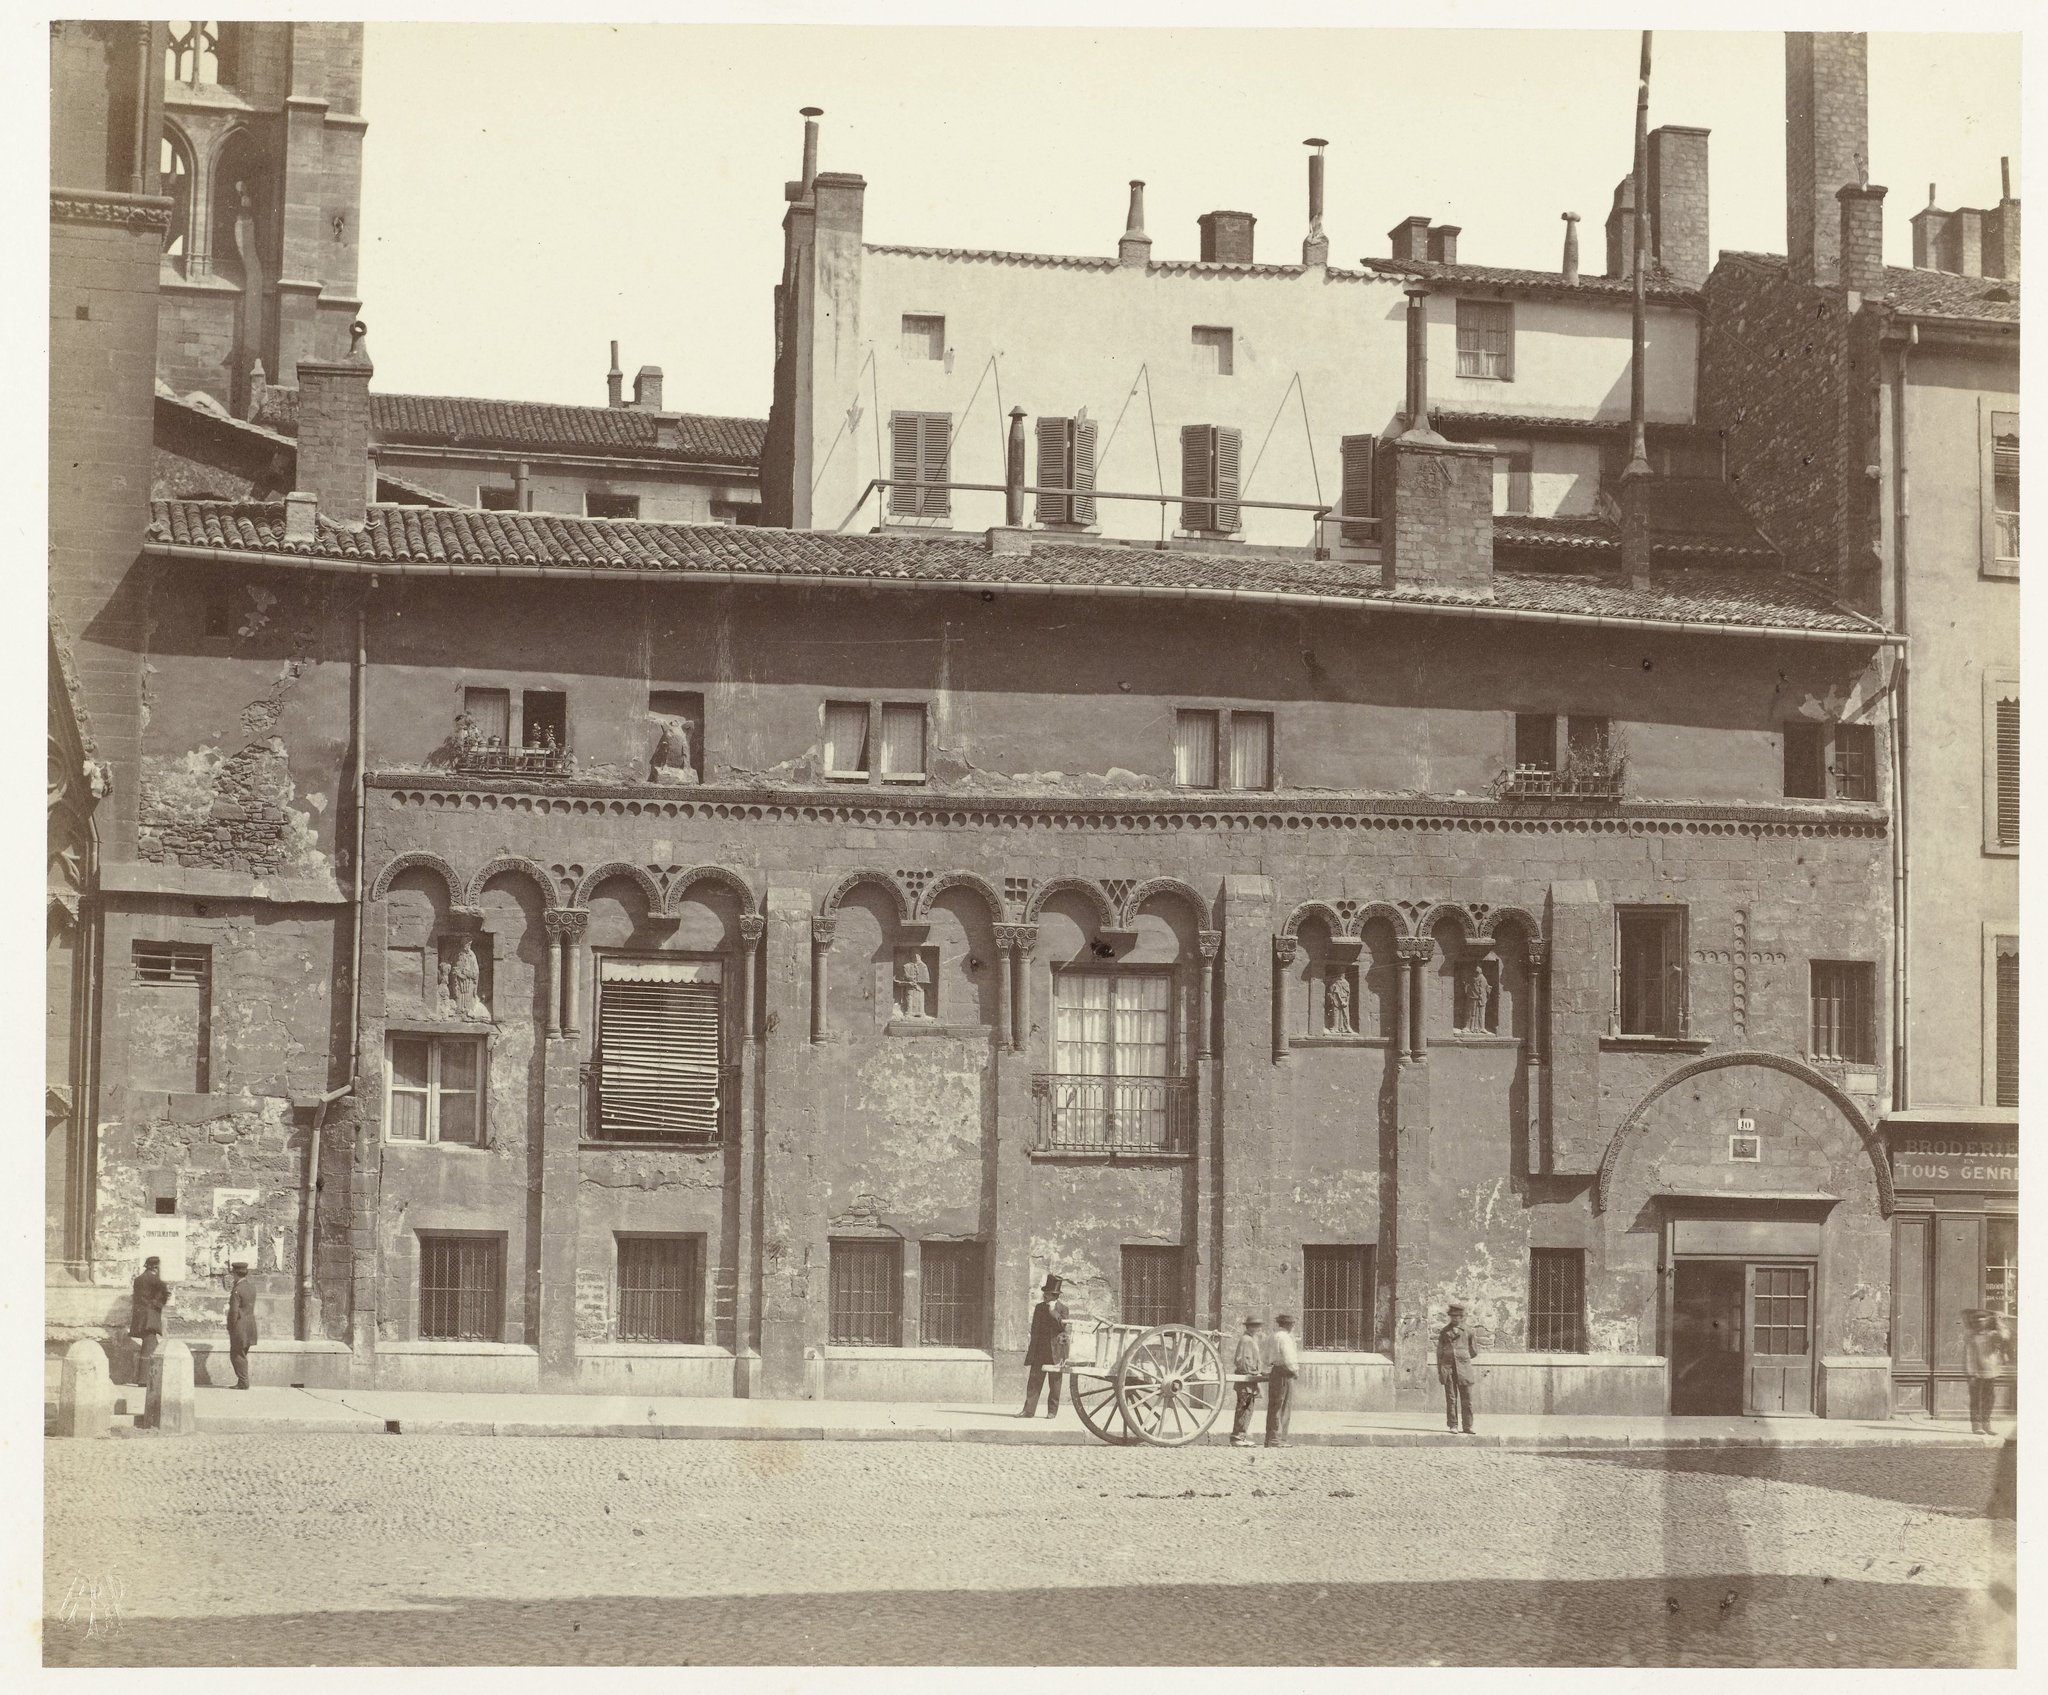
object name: photograph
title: Lyon, Kathedraal - Zangschool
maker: Anonymous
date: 1858-1861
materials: cardboard, paper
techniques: albumen print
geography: lyon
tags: interior of church, university building, college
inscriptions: address: ‘[...] 68 NEW BOND ST’, monogram: ‘APA’